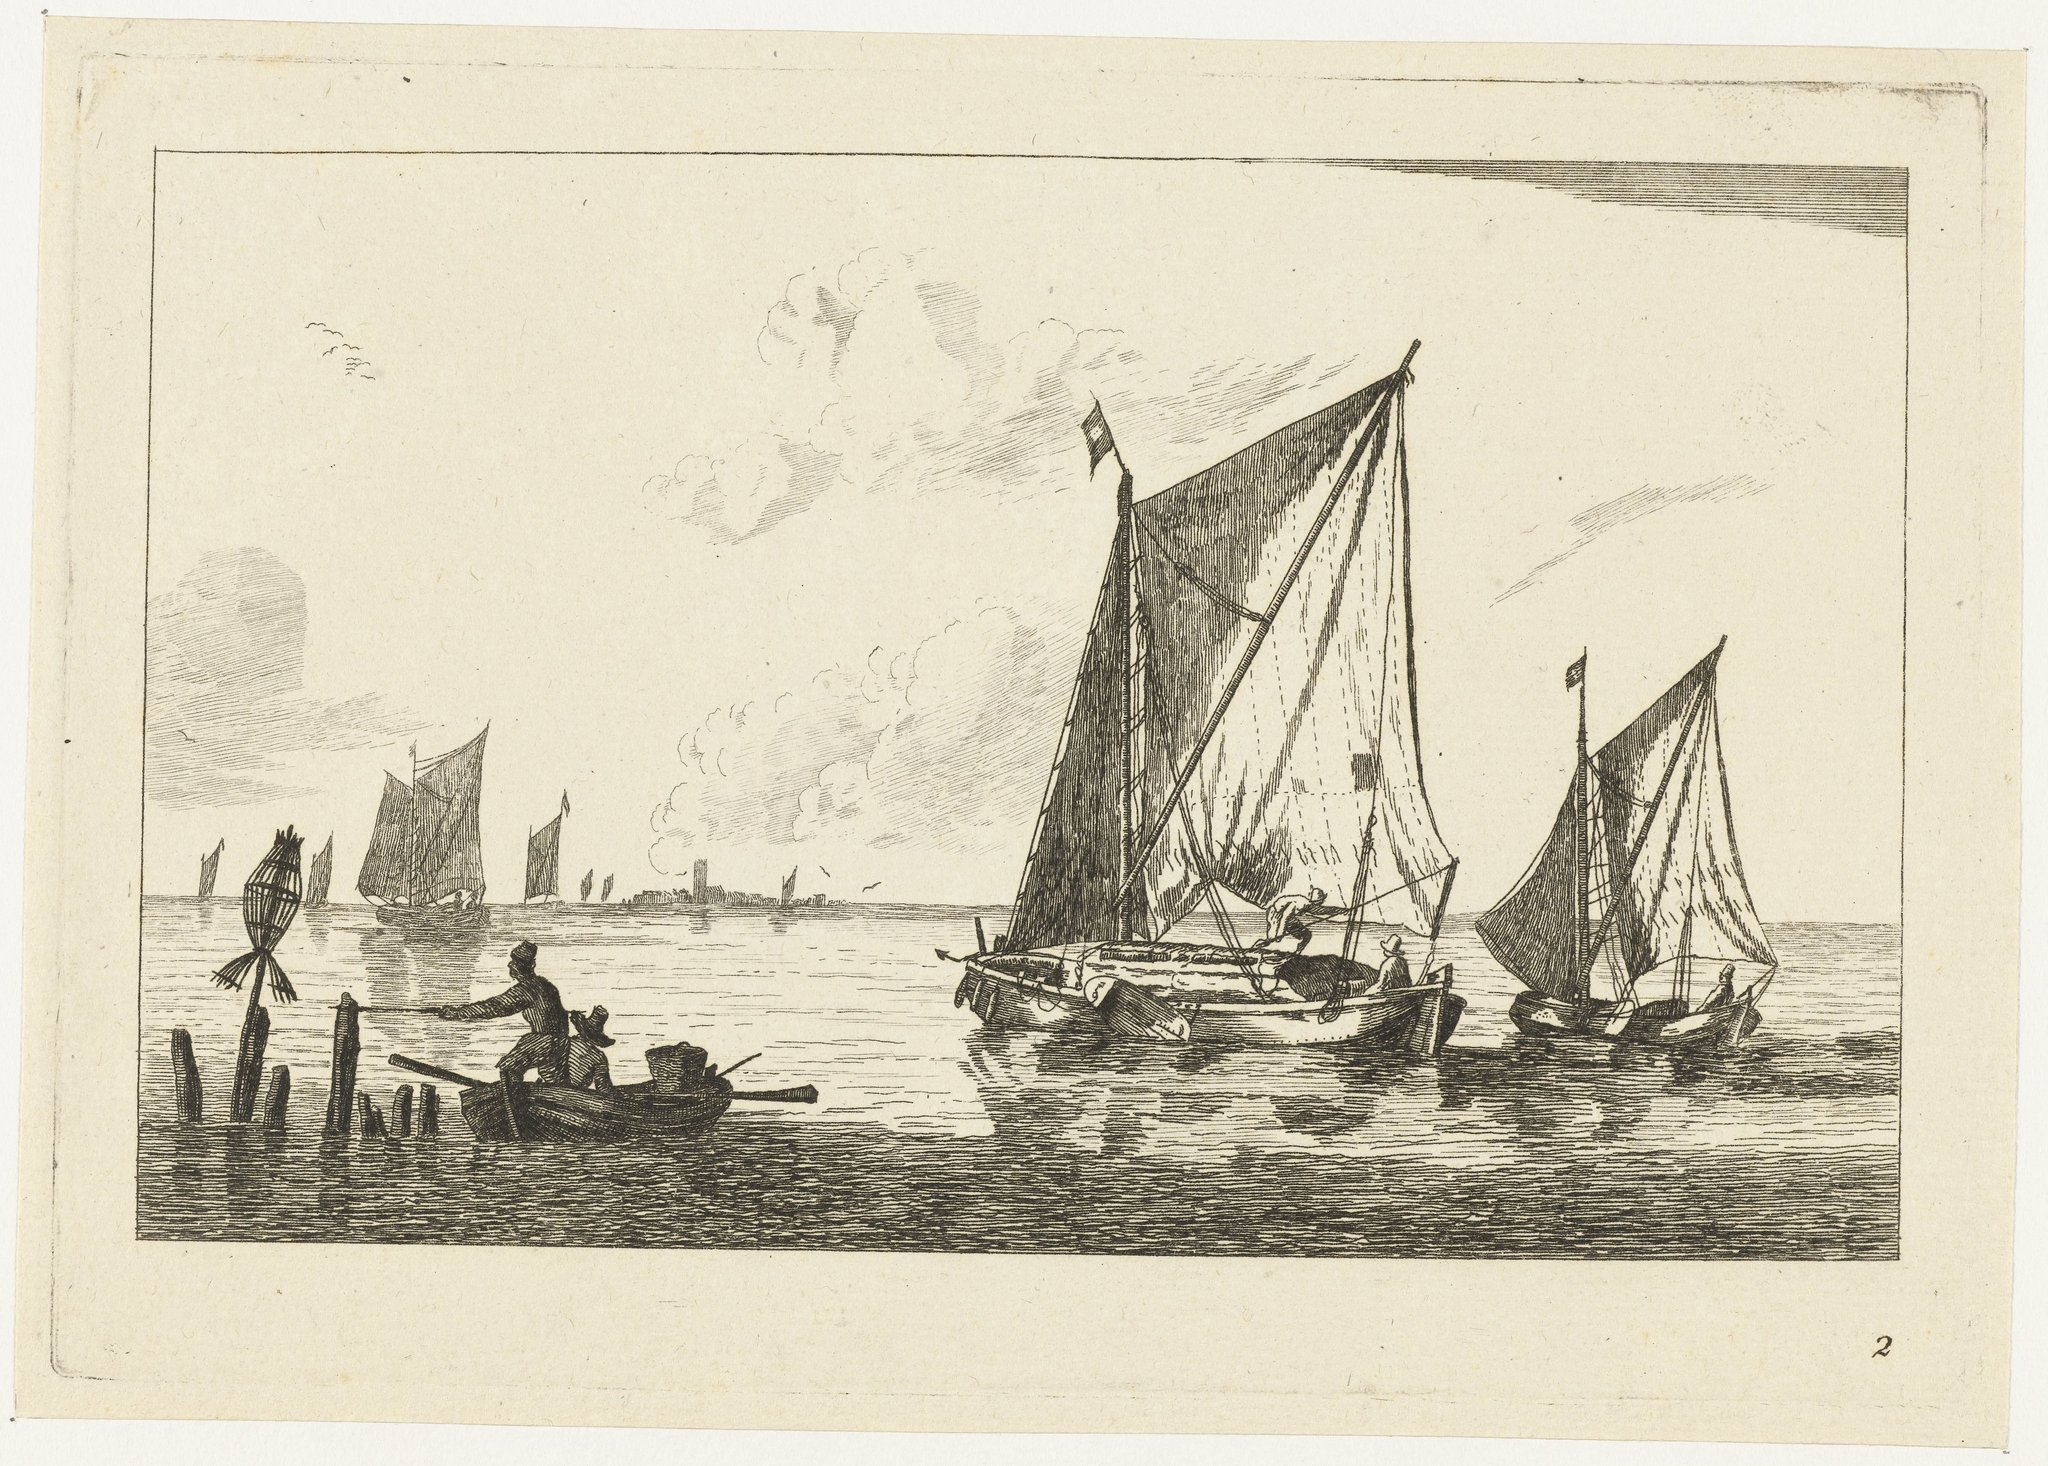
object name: print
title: Twee zeilschepen en een roeiboot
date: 1700-1799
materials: paper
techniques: etching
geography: paris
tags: sailing-ship, sailing-boat, rowing-boat, canoe, etc.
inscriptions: collector's mark: Lugt 2228a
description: Rustig water met twee zeilschepen en een roeiboot. In de verte een aantal schepen en de contouren van een stad. Kopie in spiegelbeeld.